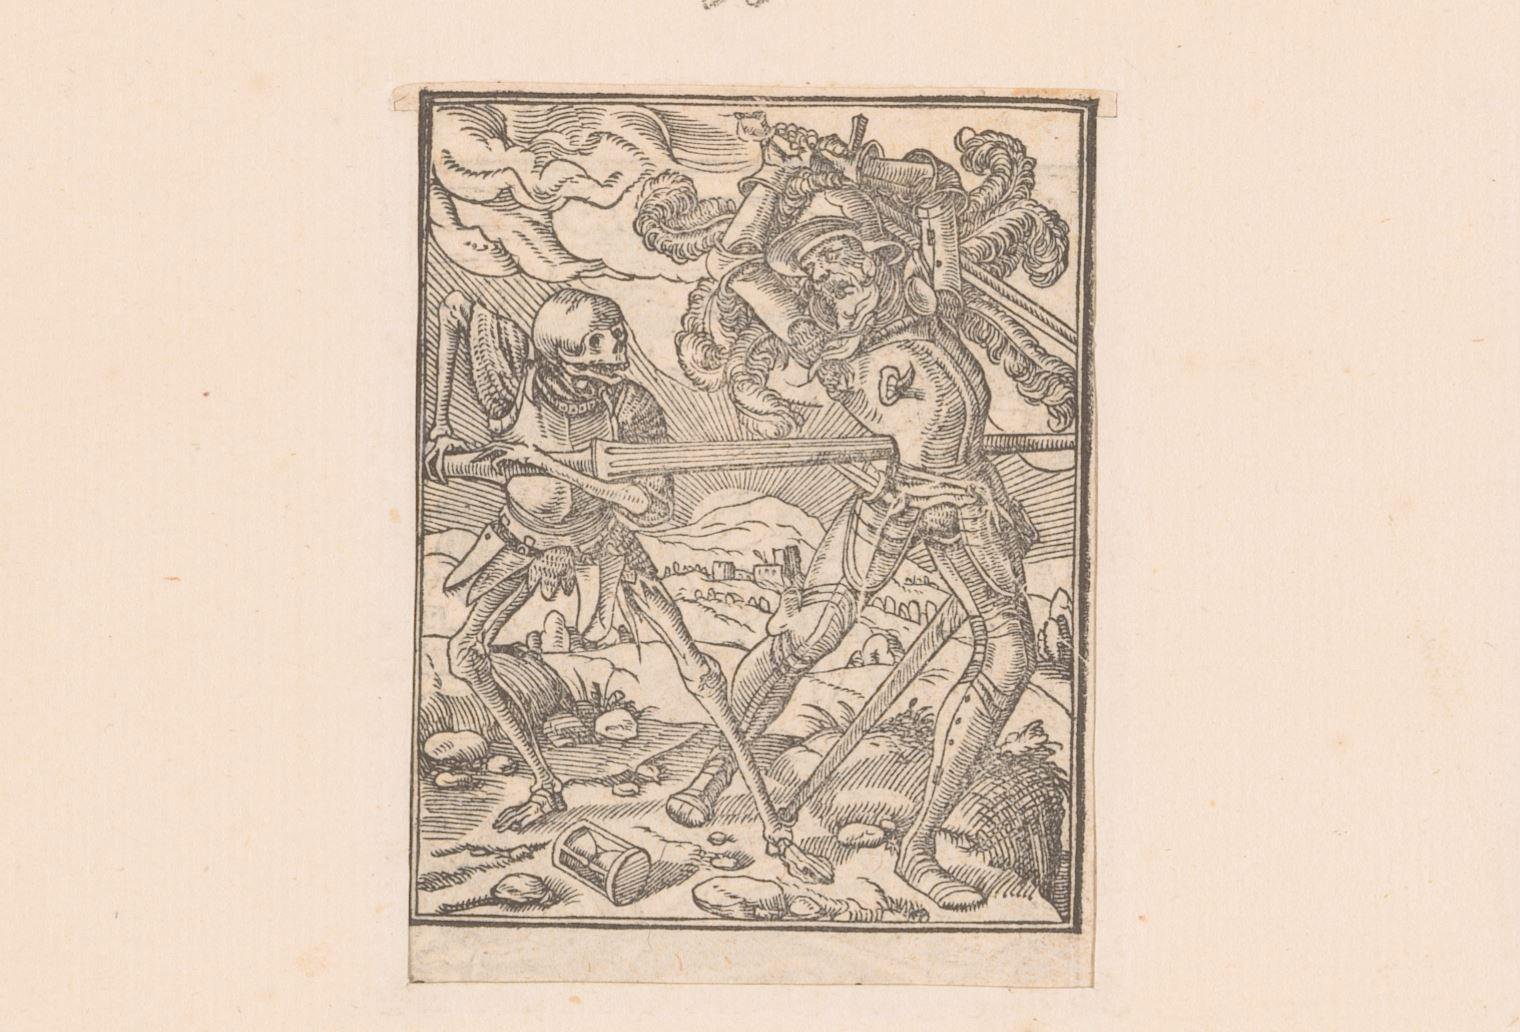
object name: print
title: Ridder met de Dood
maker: Anonymous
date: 1547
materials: paper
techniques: woodcut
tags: dance of death; death together with one or more human beings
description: Kopie van een prent van Hans Holbein de jongere uit 1538, voor het eerst gepubliceerd in: Imagines mortis (...). Lyon: Johannes Frellon, 1547.